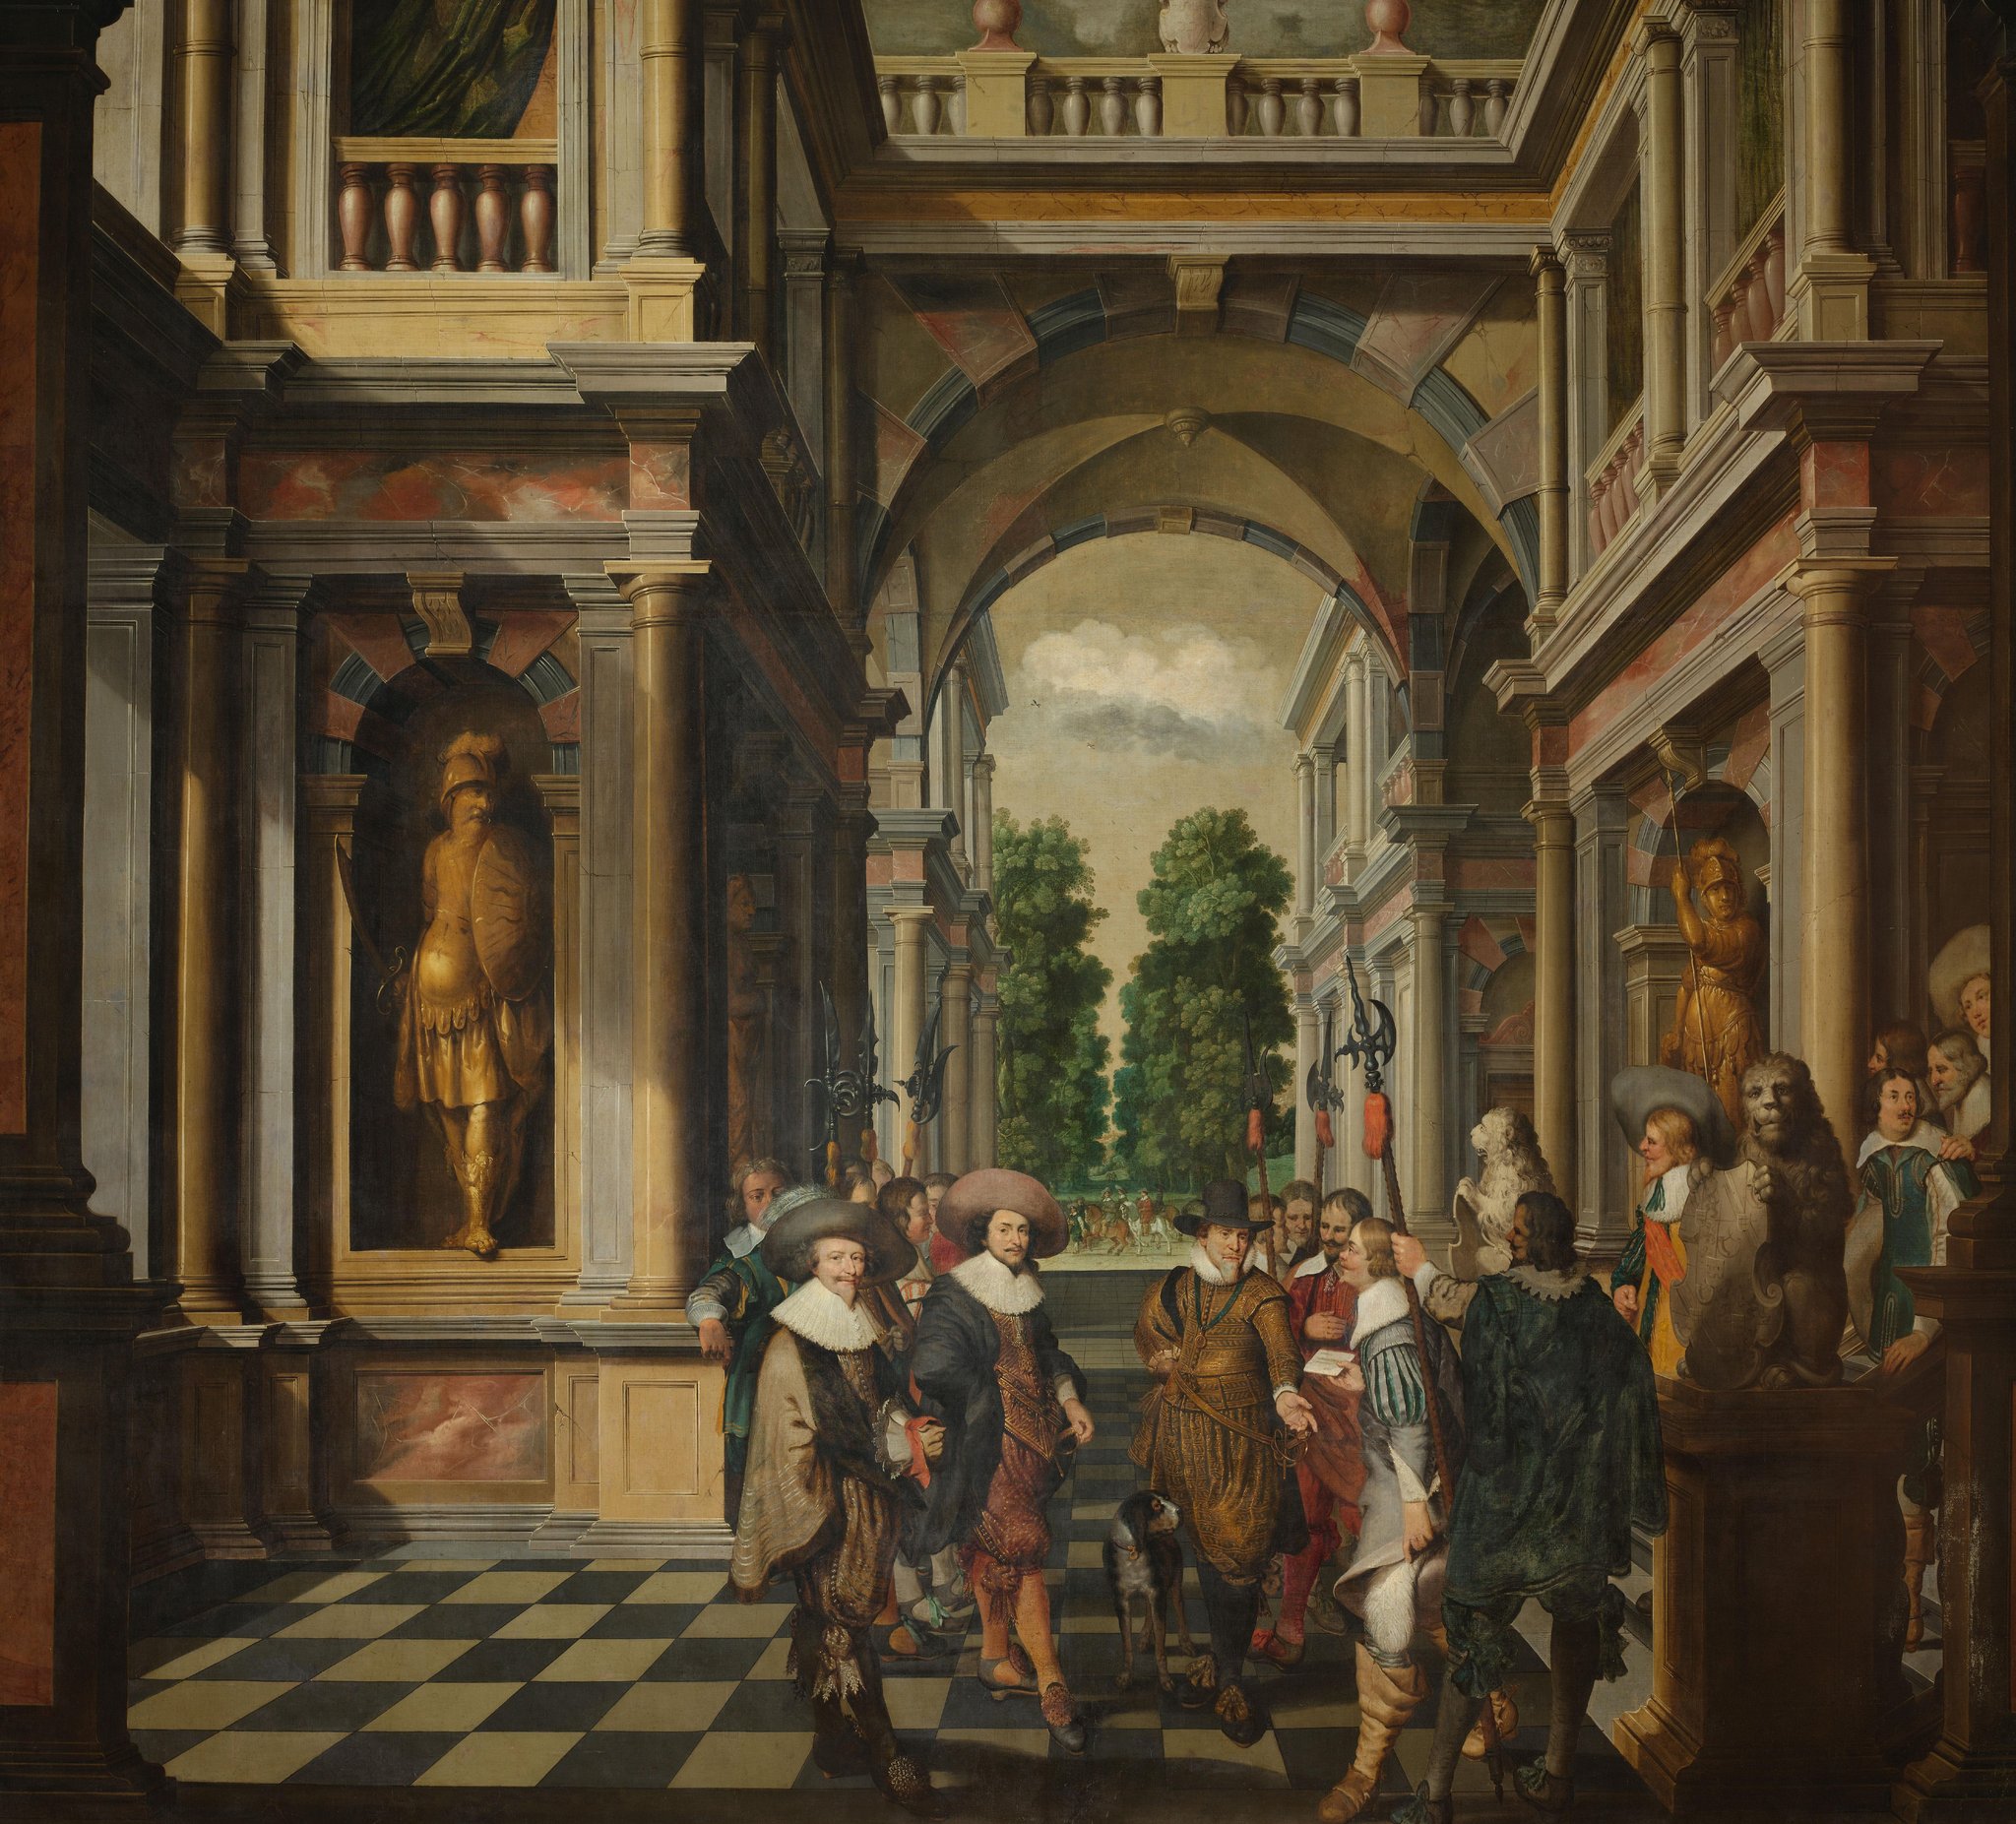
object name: painting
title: A Seven-Part Decorative Sequence: A Gallery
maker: dirck van delen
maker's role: painter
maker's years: 1604-1671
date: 1630-1632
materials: canvas, oil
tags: maurice (prince of orange), amberg, frederik v (keurvorst van de palts, koning van bohemen), earl, floris ii van pallandt (graaf van culemborg), palace - aa - civic architecture: inside, historical persons, piece of sculpture, reproduction of a piece of sculpture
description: Onderdeel van een zevendelige kamerbeschildering in vijf stukken met afbeeldingen van een interieur, twee galerijen en twee buitentrappen, bevolkt met talrijke personen. Dit stuk toont een galerij van een paleis met ornamentale architectuur en standbeelden. Met (van links naar rechts) portretten van Floris II van Pallandt, graaf van Culemborg, Frederik V, koning van Bohemen (de winterkoning) en prins Maurits.